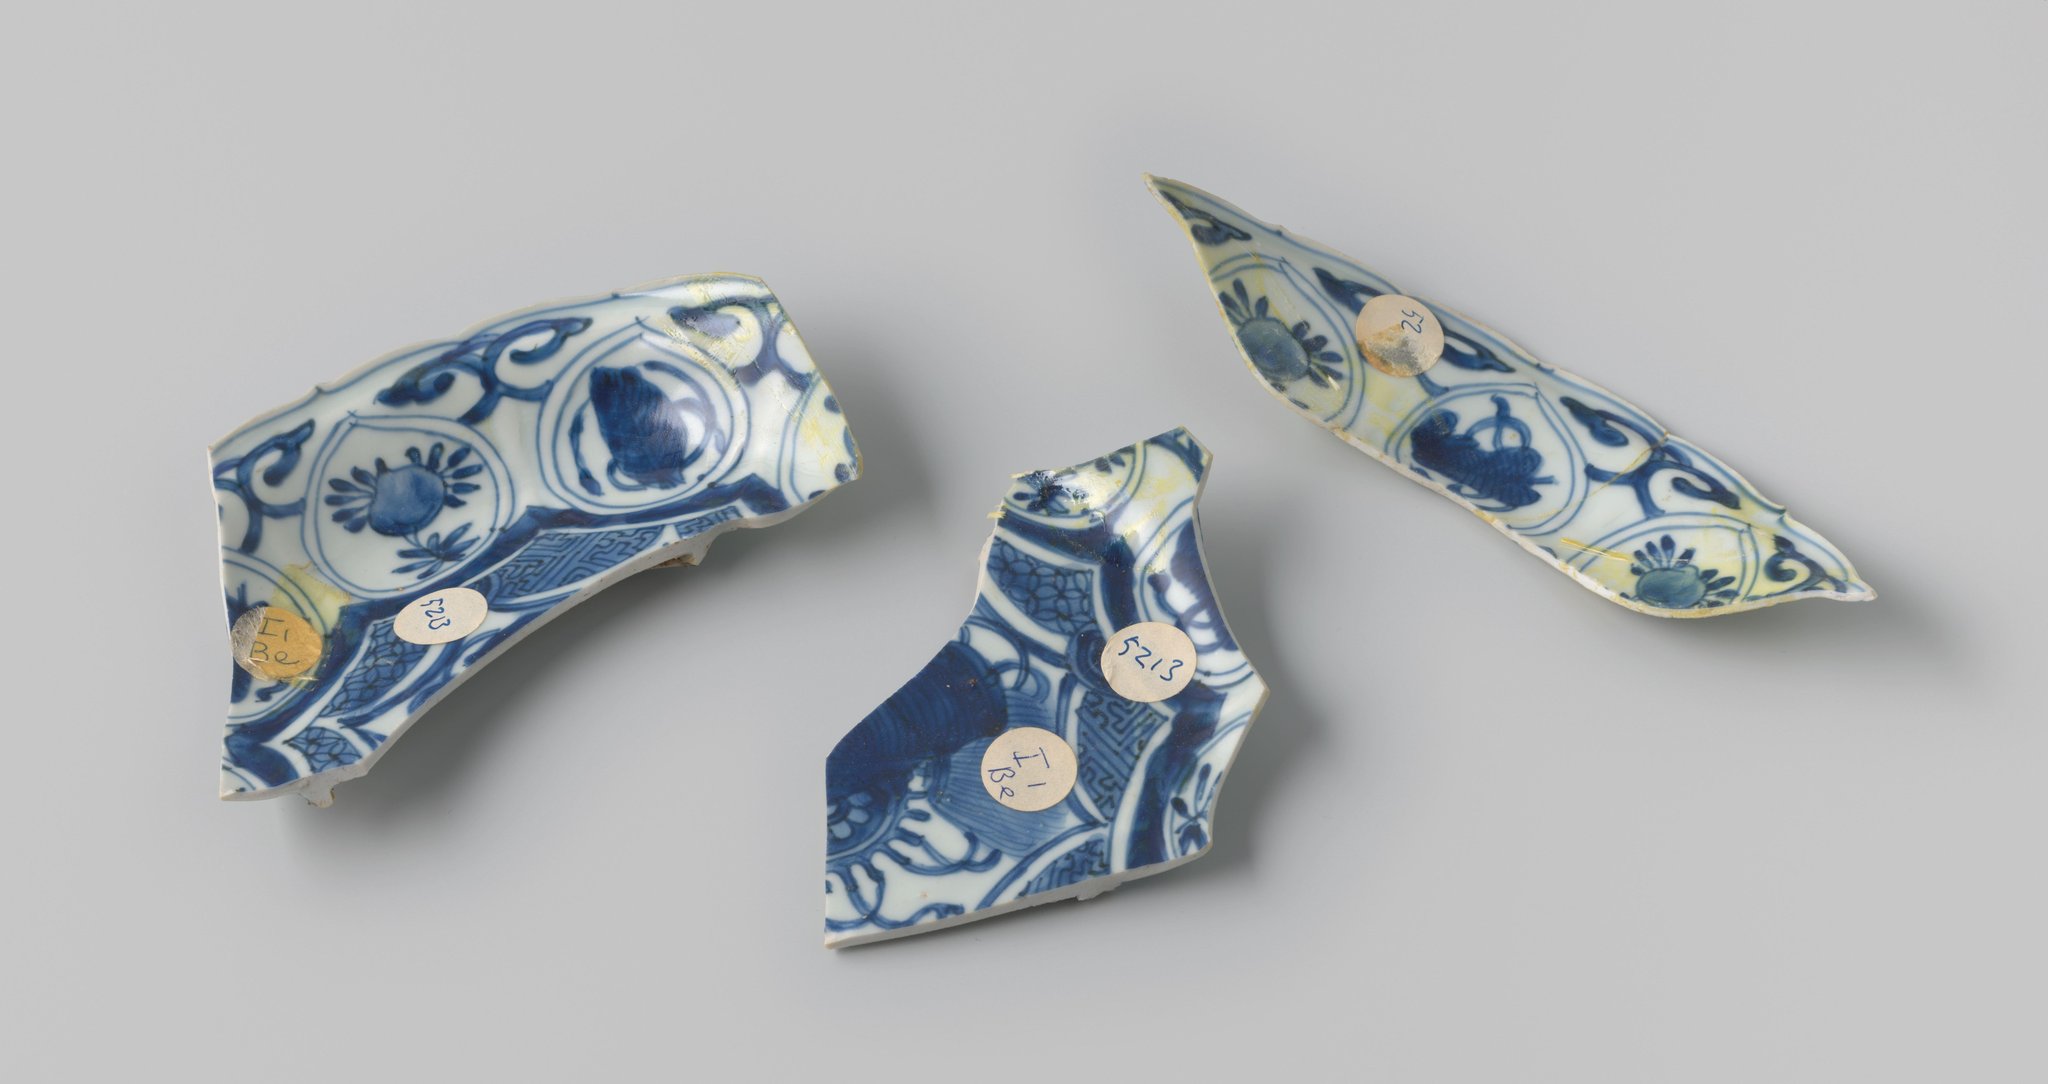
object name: sherd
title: Scherven van een bord uit V.O.C.-schip de 'Witte Leeuw'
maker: Anonymous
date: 1613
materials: bone china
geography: jingdezhen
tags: verenigde oostindische compagnie, sint-helena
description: A dish without a flattened rim. An eight-sided thickly drawn medallion. A central decoration of a combination of symbols. The medallions decorated with alternately peaches and symbols.